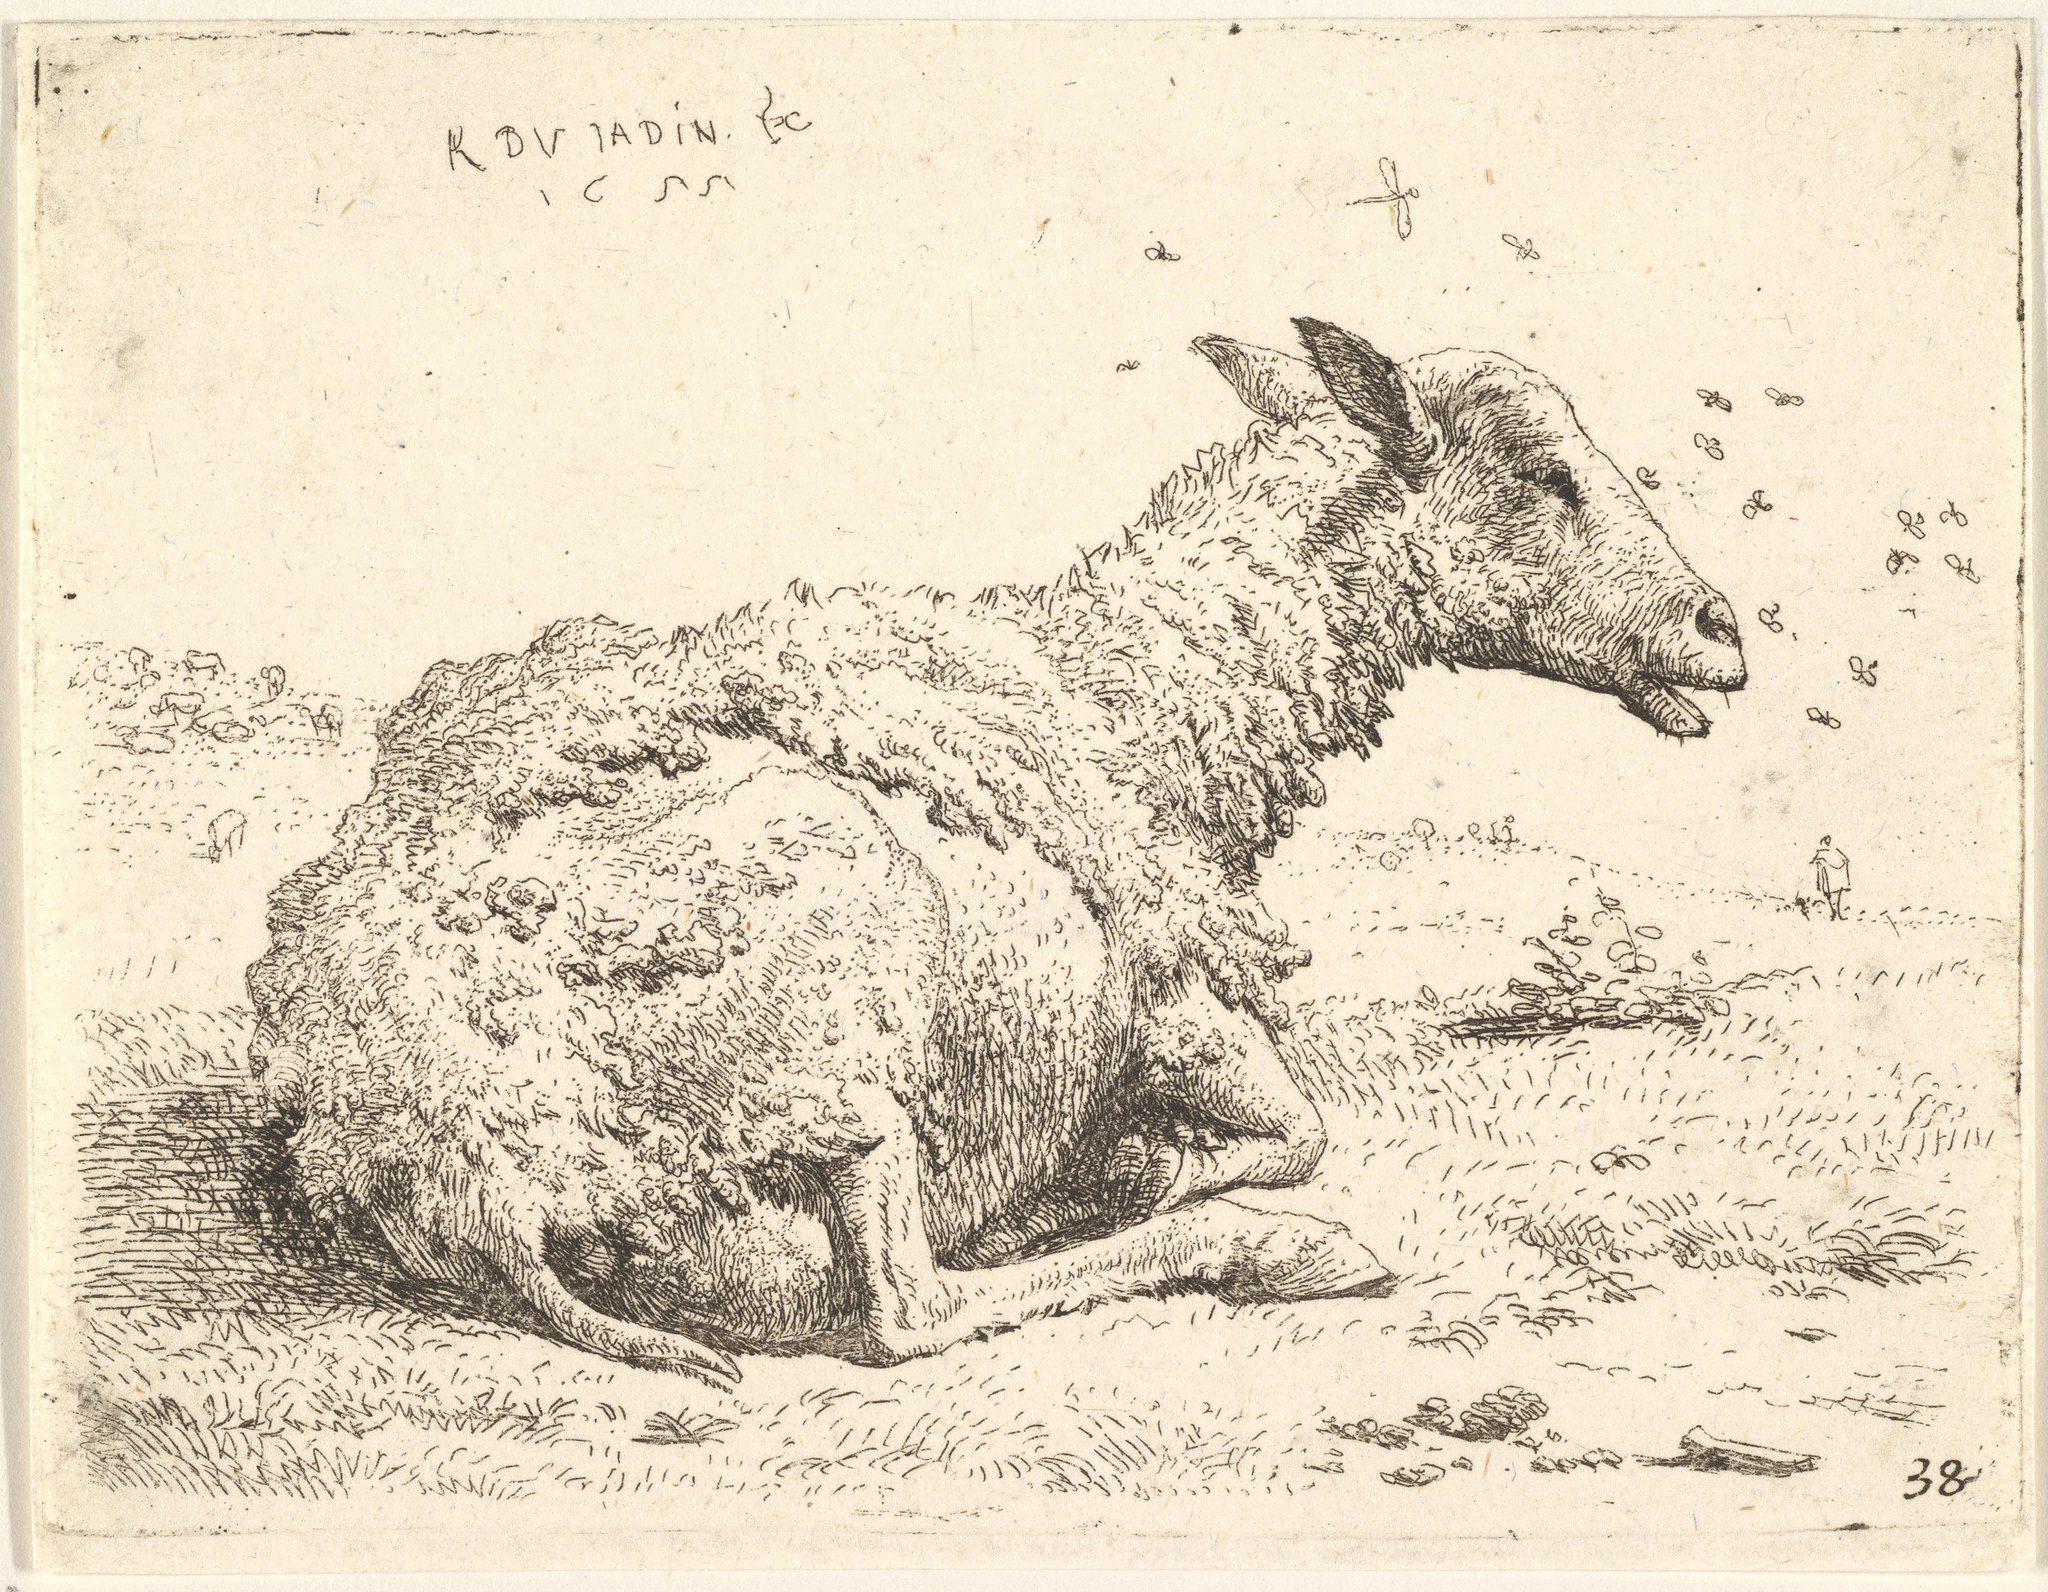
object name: print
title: Partially shorn sheep lying in the grass with insects hovering around its head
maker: karel dujardin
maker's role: artist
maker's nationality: dutch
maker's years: 1622-1678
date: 1655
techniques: etching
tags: insects,sheep